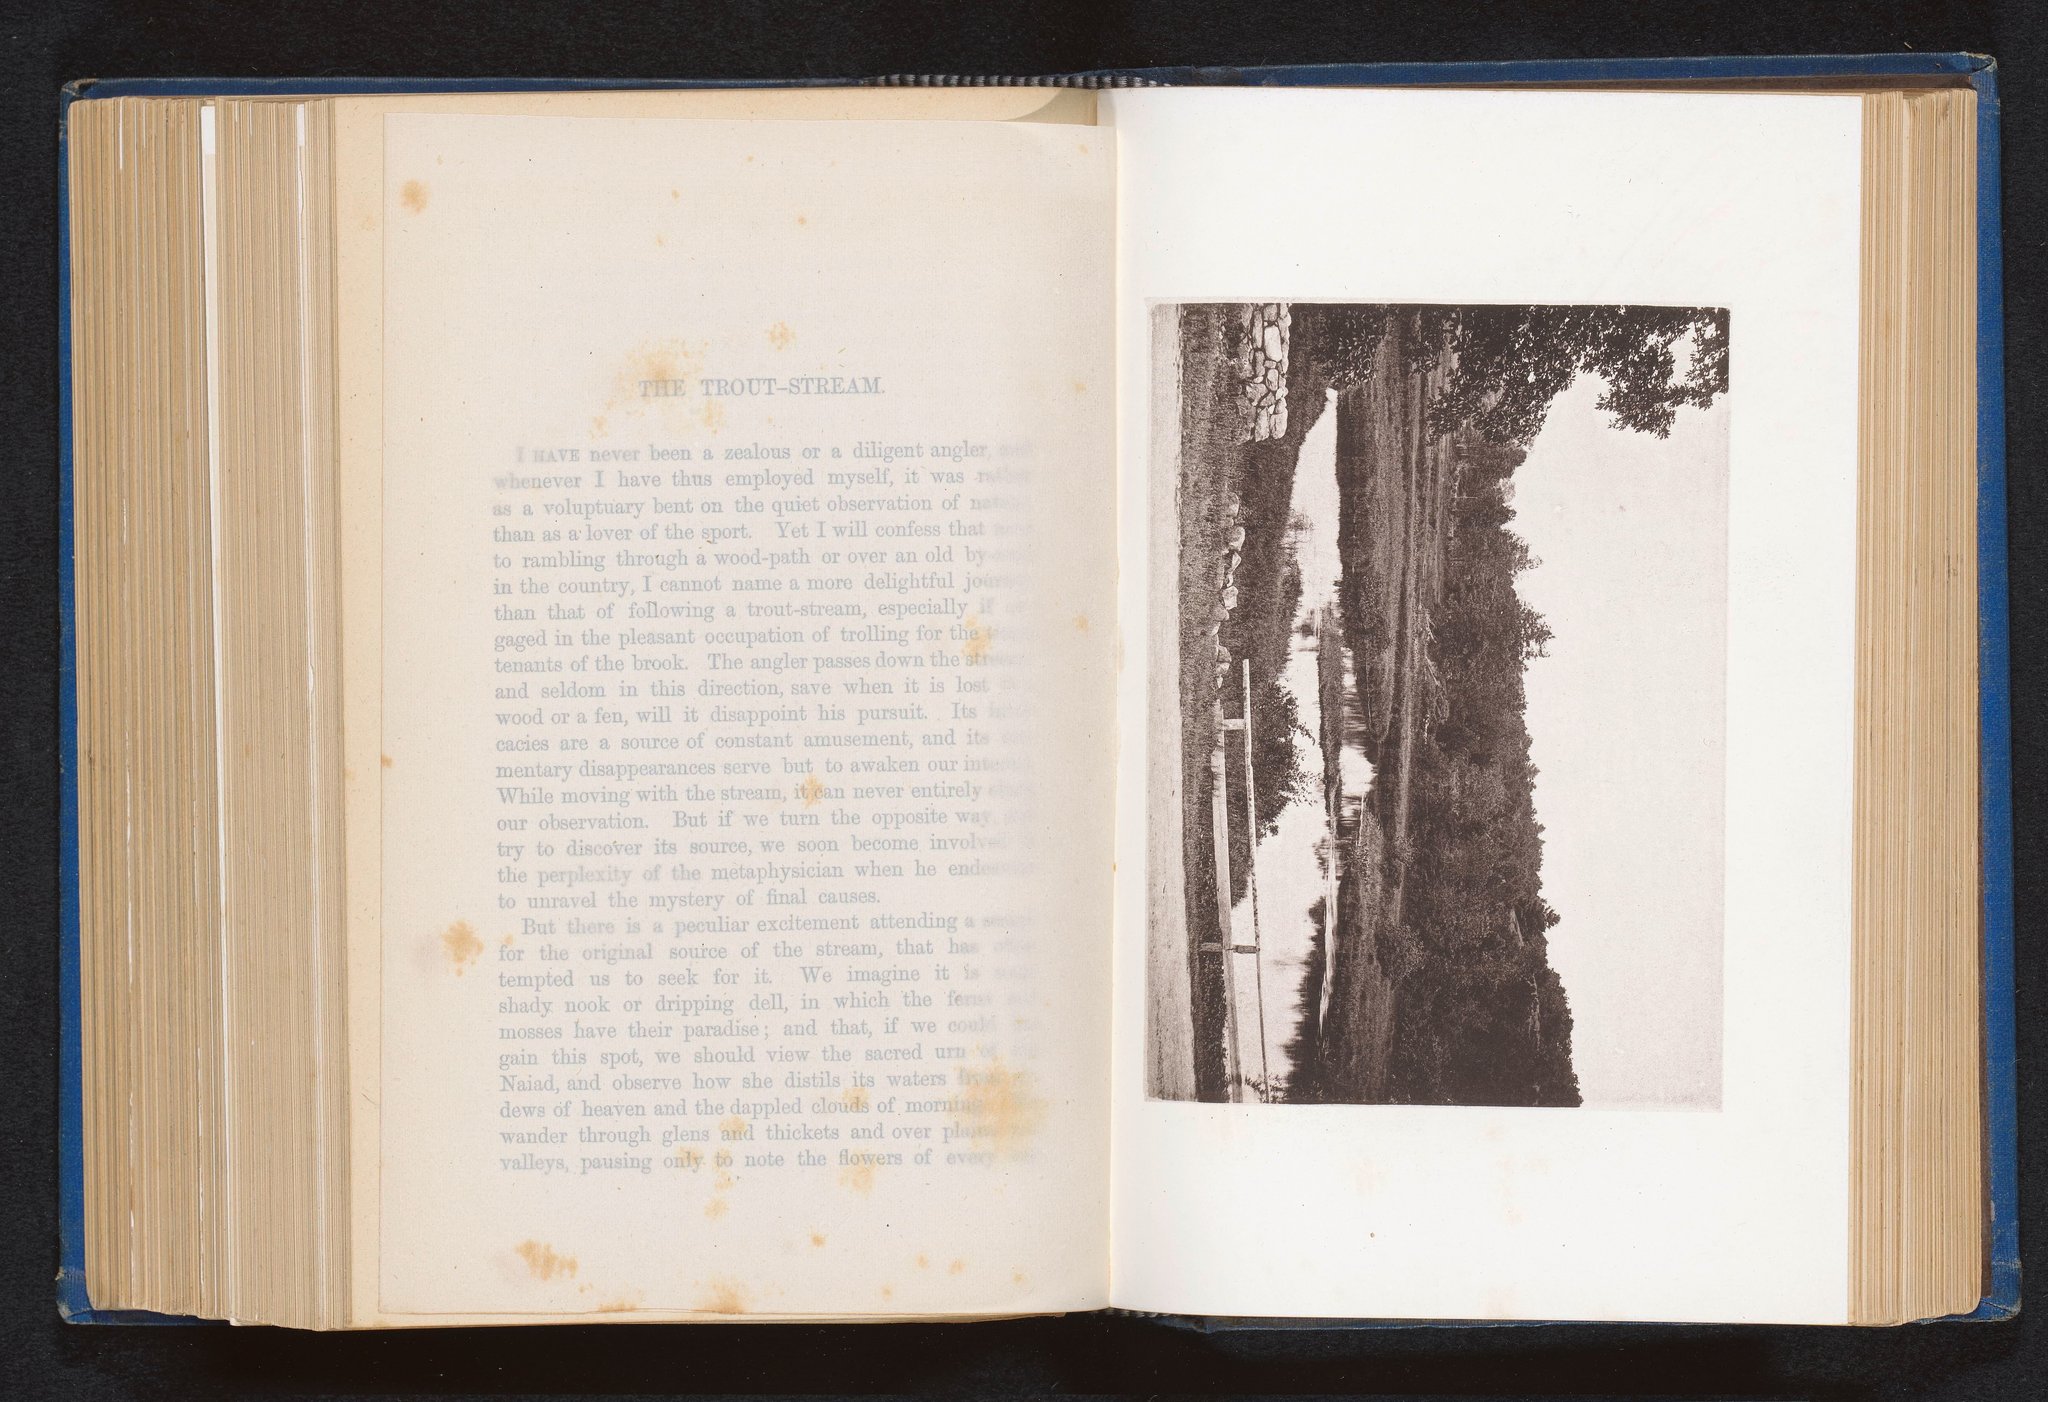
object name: page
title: Gezicht op de Ipswich te Middleton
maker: Anonymous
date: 1872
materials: paper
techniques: photograph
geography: middleton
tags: landscapes, river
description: Prent op tweede ongenummerde pagina na pagina 328.